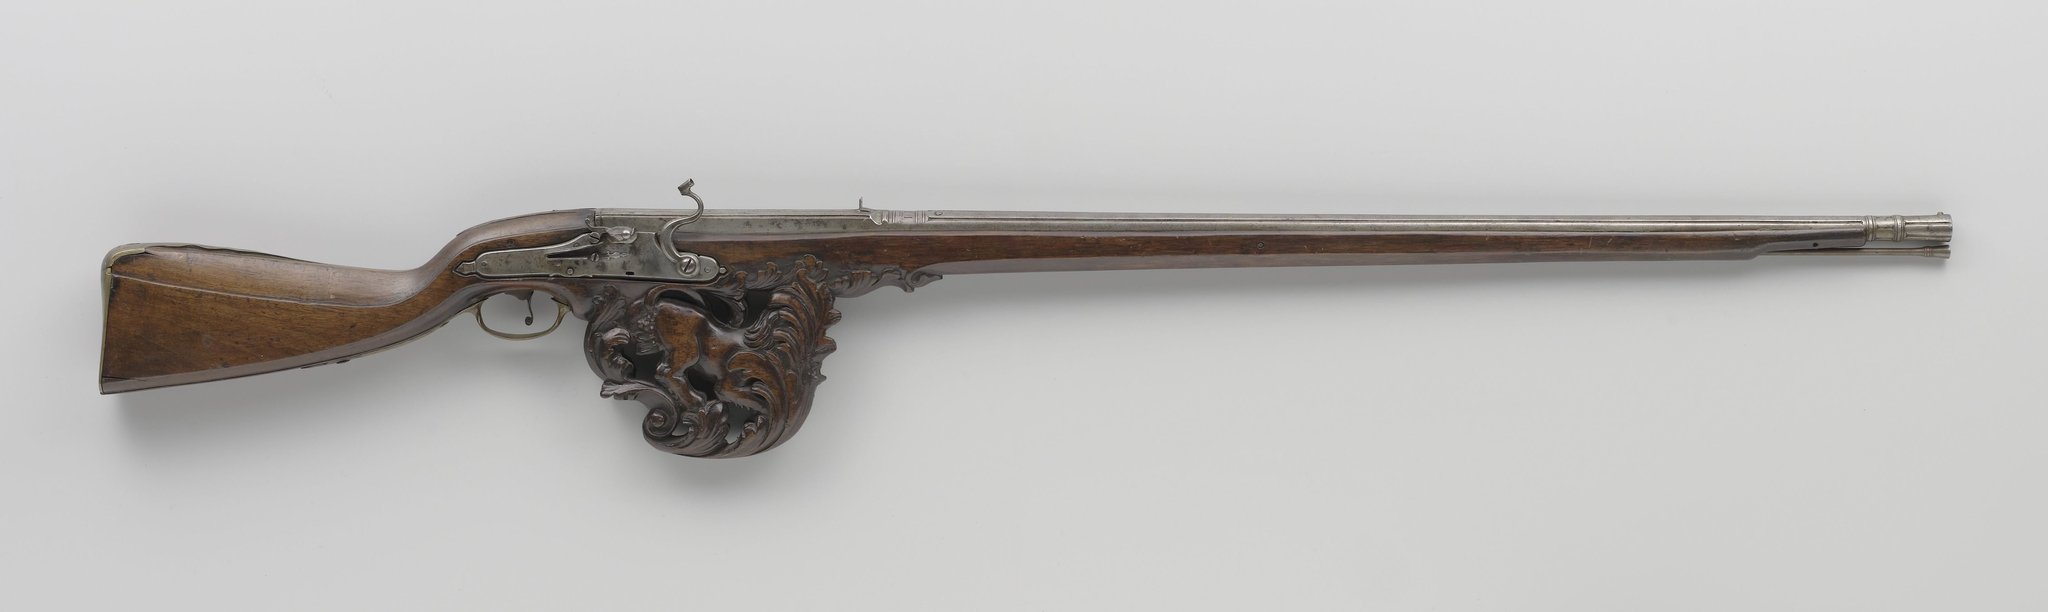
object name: target rifle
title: Doelroer met tondelslot en achttiende-eeuwse lade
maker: Anonymous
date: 1611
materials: brass, iron, steel, wood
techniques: printing, cutting, gilding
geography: goes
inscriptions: mark: ‘1611’, number: ‘XXIIII’, inscription: ‘VAN GOES’